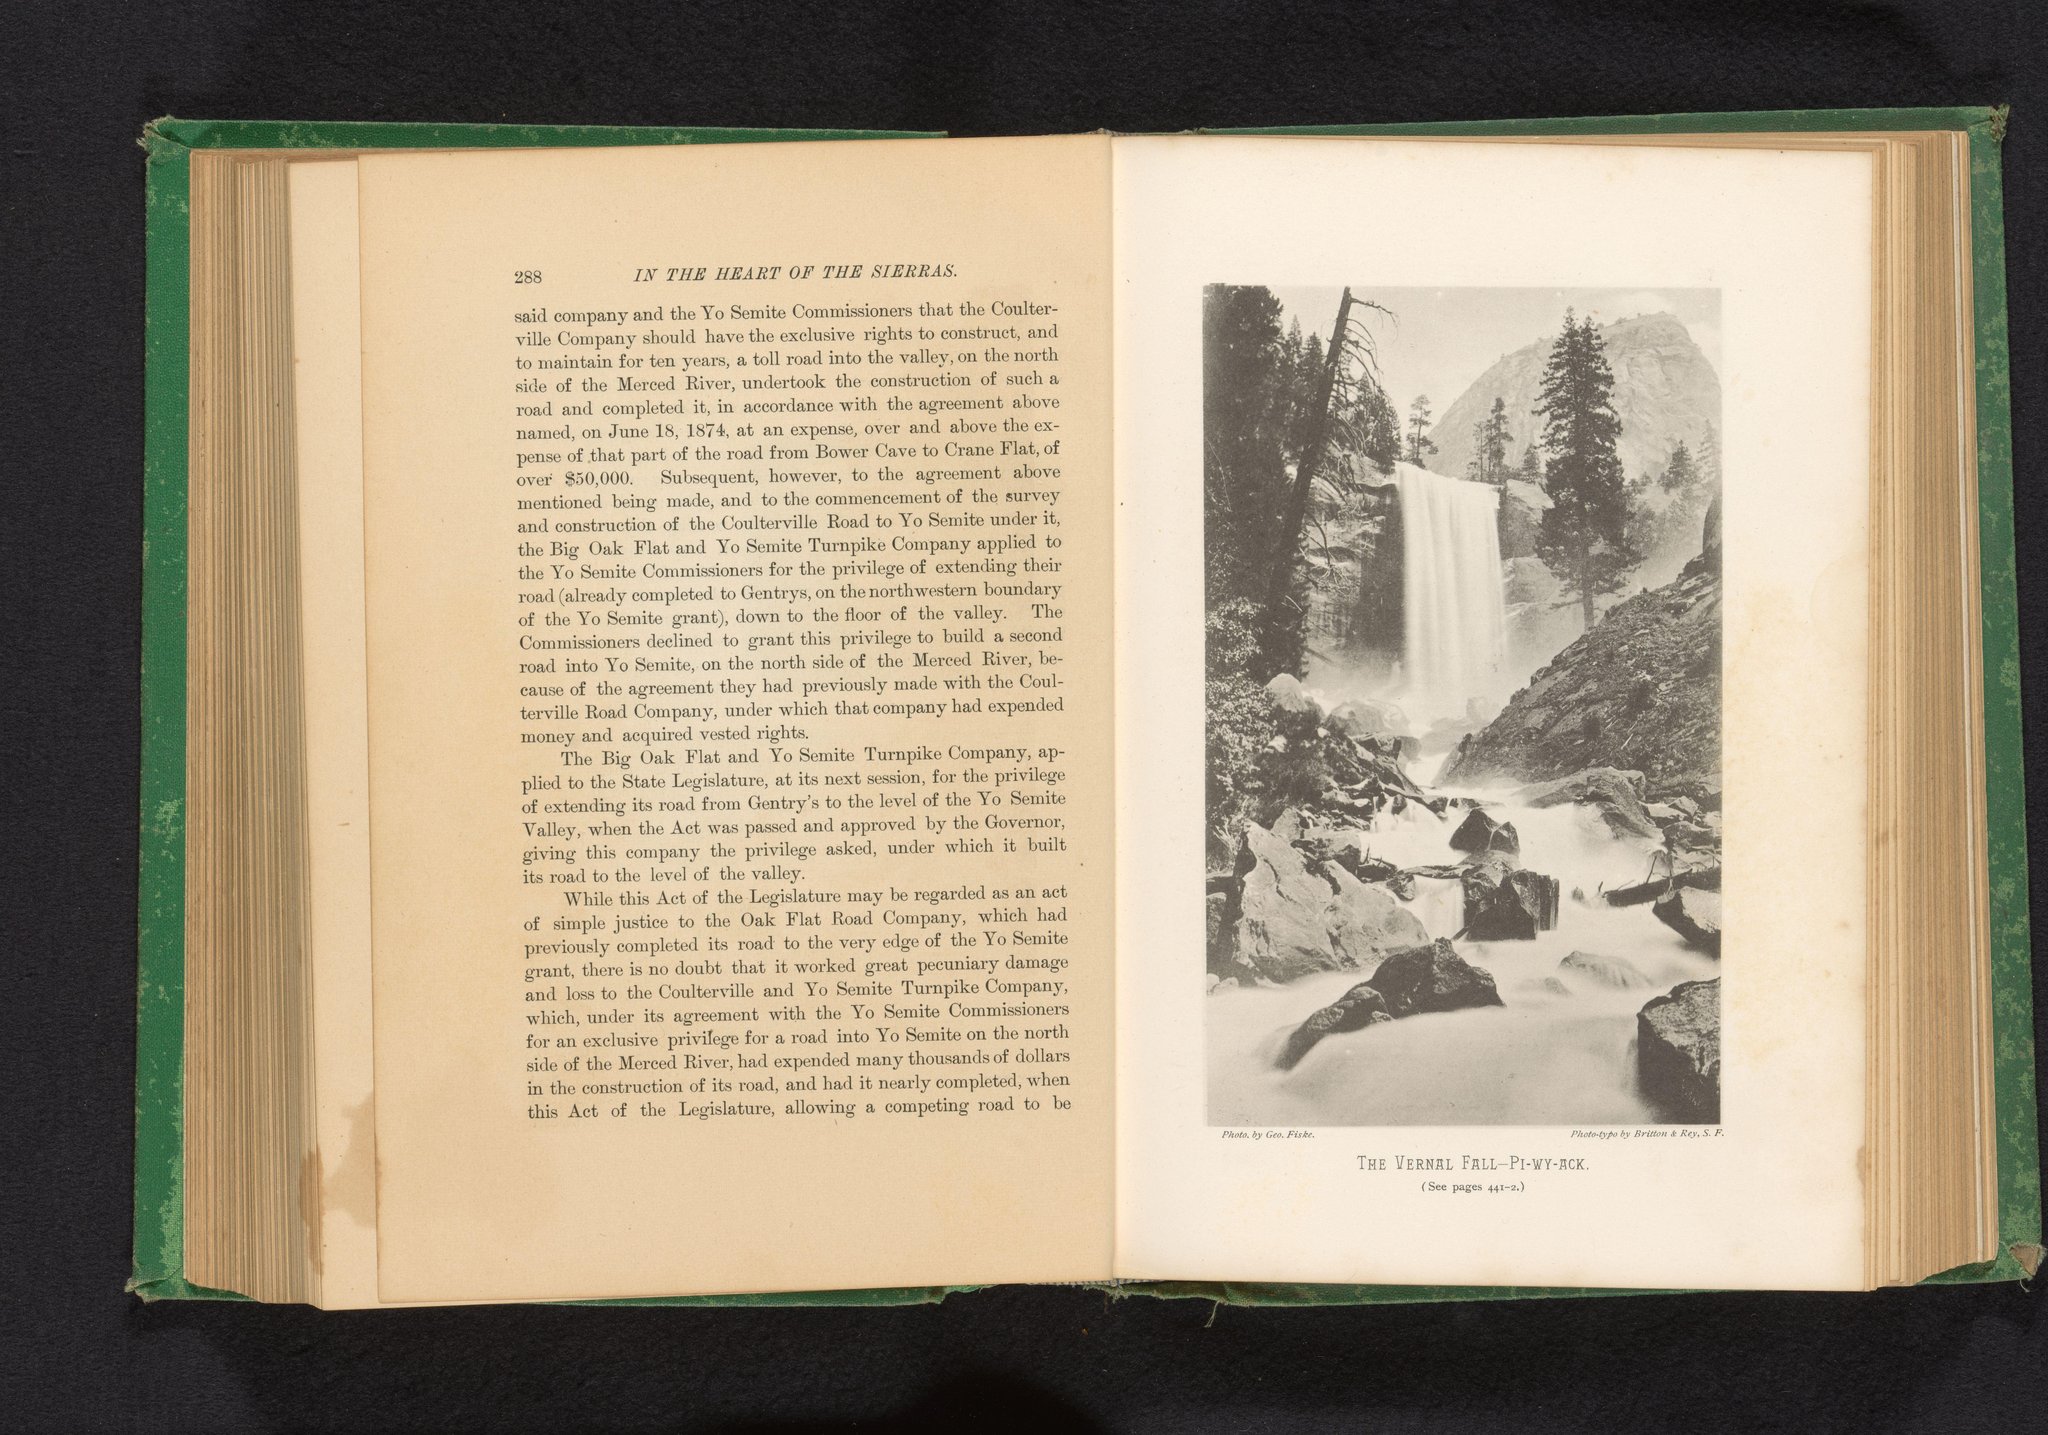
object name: photomechanical print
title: Gezicht op de Vernal Fall in Yosemite Valley, Californië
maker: george fiske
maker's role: fotograaf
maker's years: 1835-1918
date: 1881-1886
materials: paper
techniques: photograph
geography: san francisco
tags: waterfall, mountains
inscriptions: inscription: ‘(See pages 441-2.)’